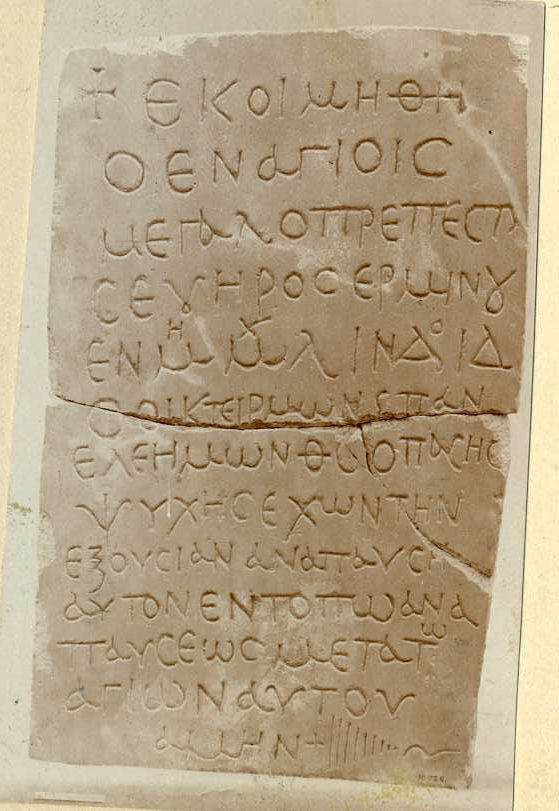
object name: stele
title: Inscribed Stele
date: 301-500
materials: stone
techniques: incising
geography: egypt